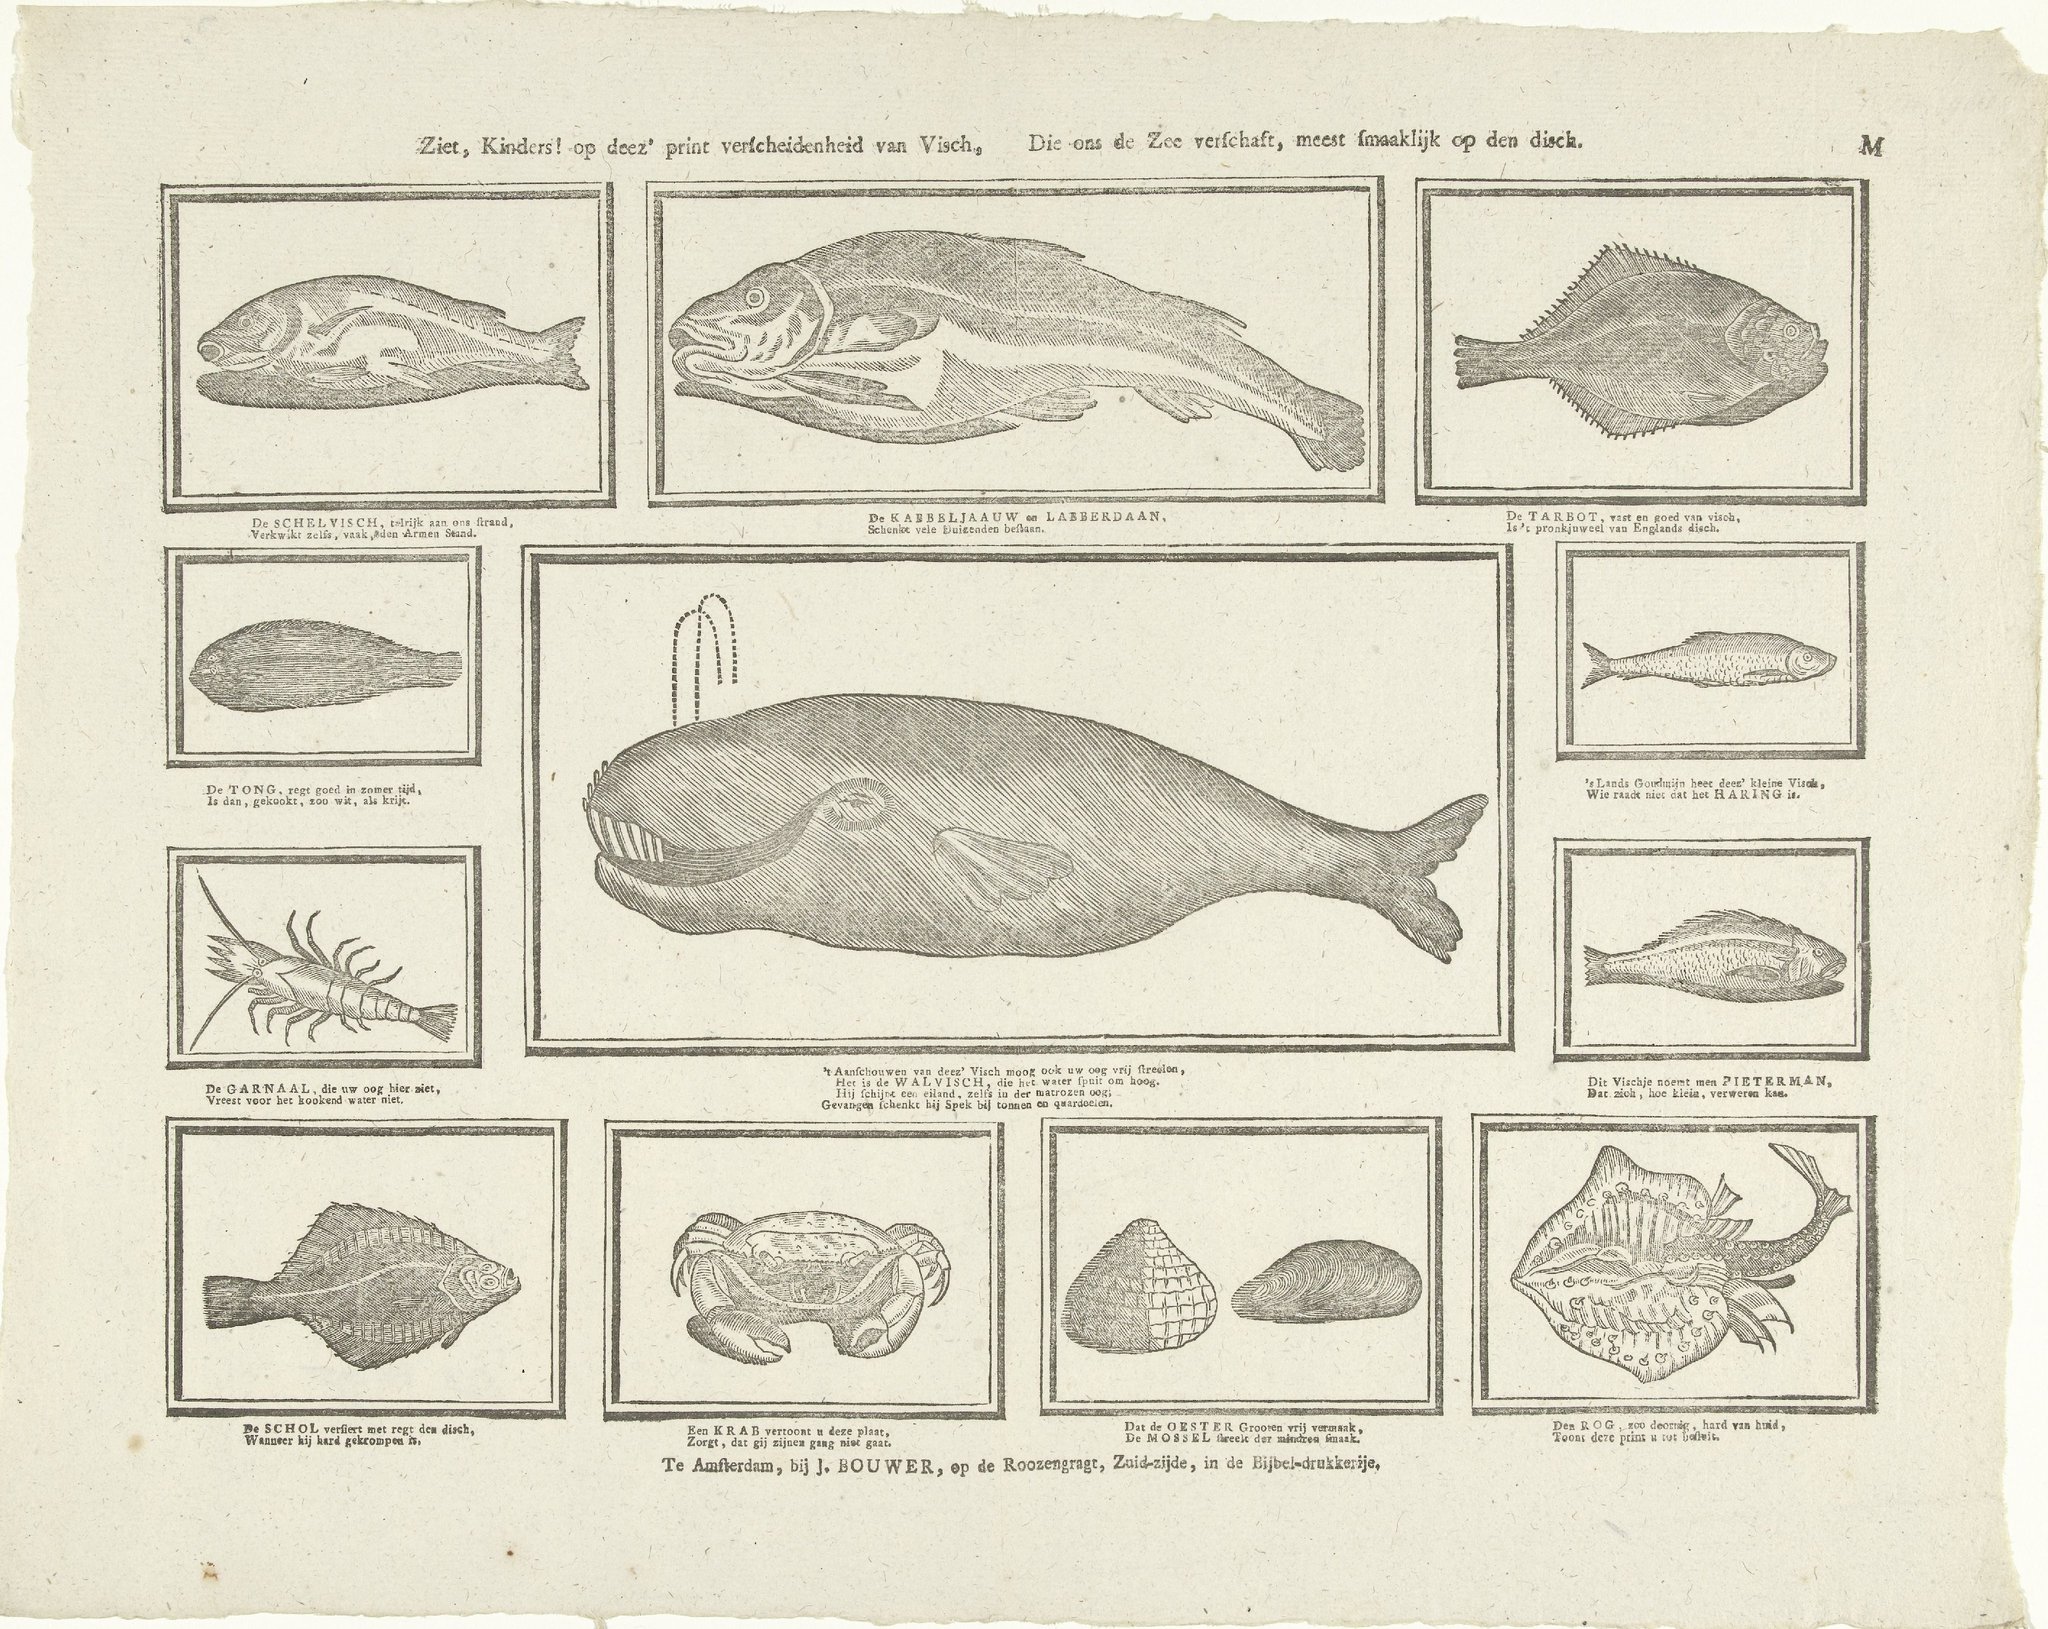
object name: print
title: Ziet, kinders! op deez' print verscheidenheid van visch, Die ons de zee verschaft, meest smaaklijk op den disch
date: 1805-1808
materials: paper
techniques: letterpress printing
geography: netherlands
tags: arthropods, fishes, molluscs, swimming mammals: whale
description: Blad met 12 voorstellingen van vissen, een walvis en schaaldieren. Onder elke afbeelding een tweeregelig vers met de naam van het dier. Genummerd rechtsboven: M.